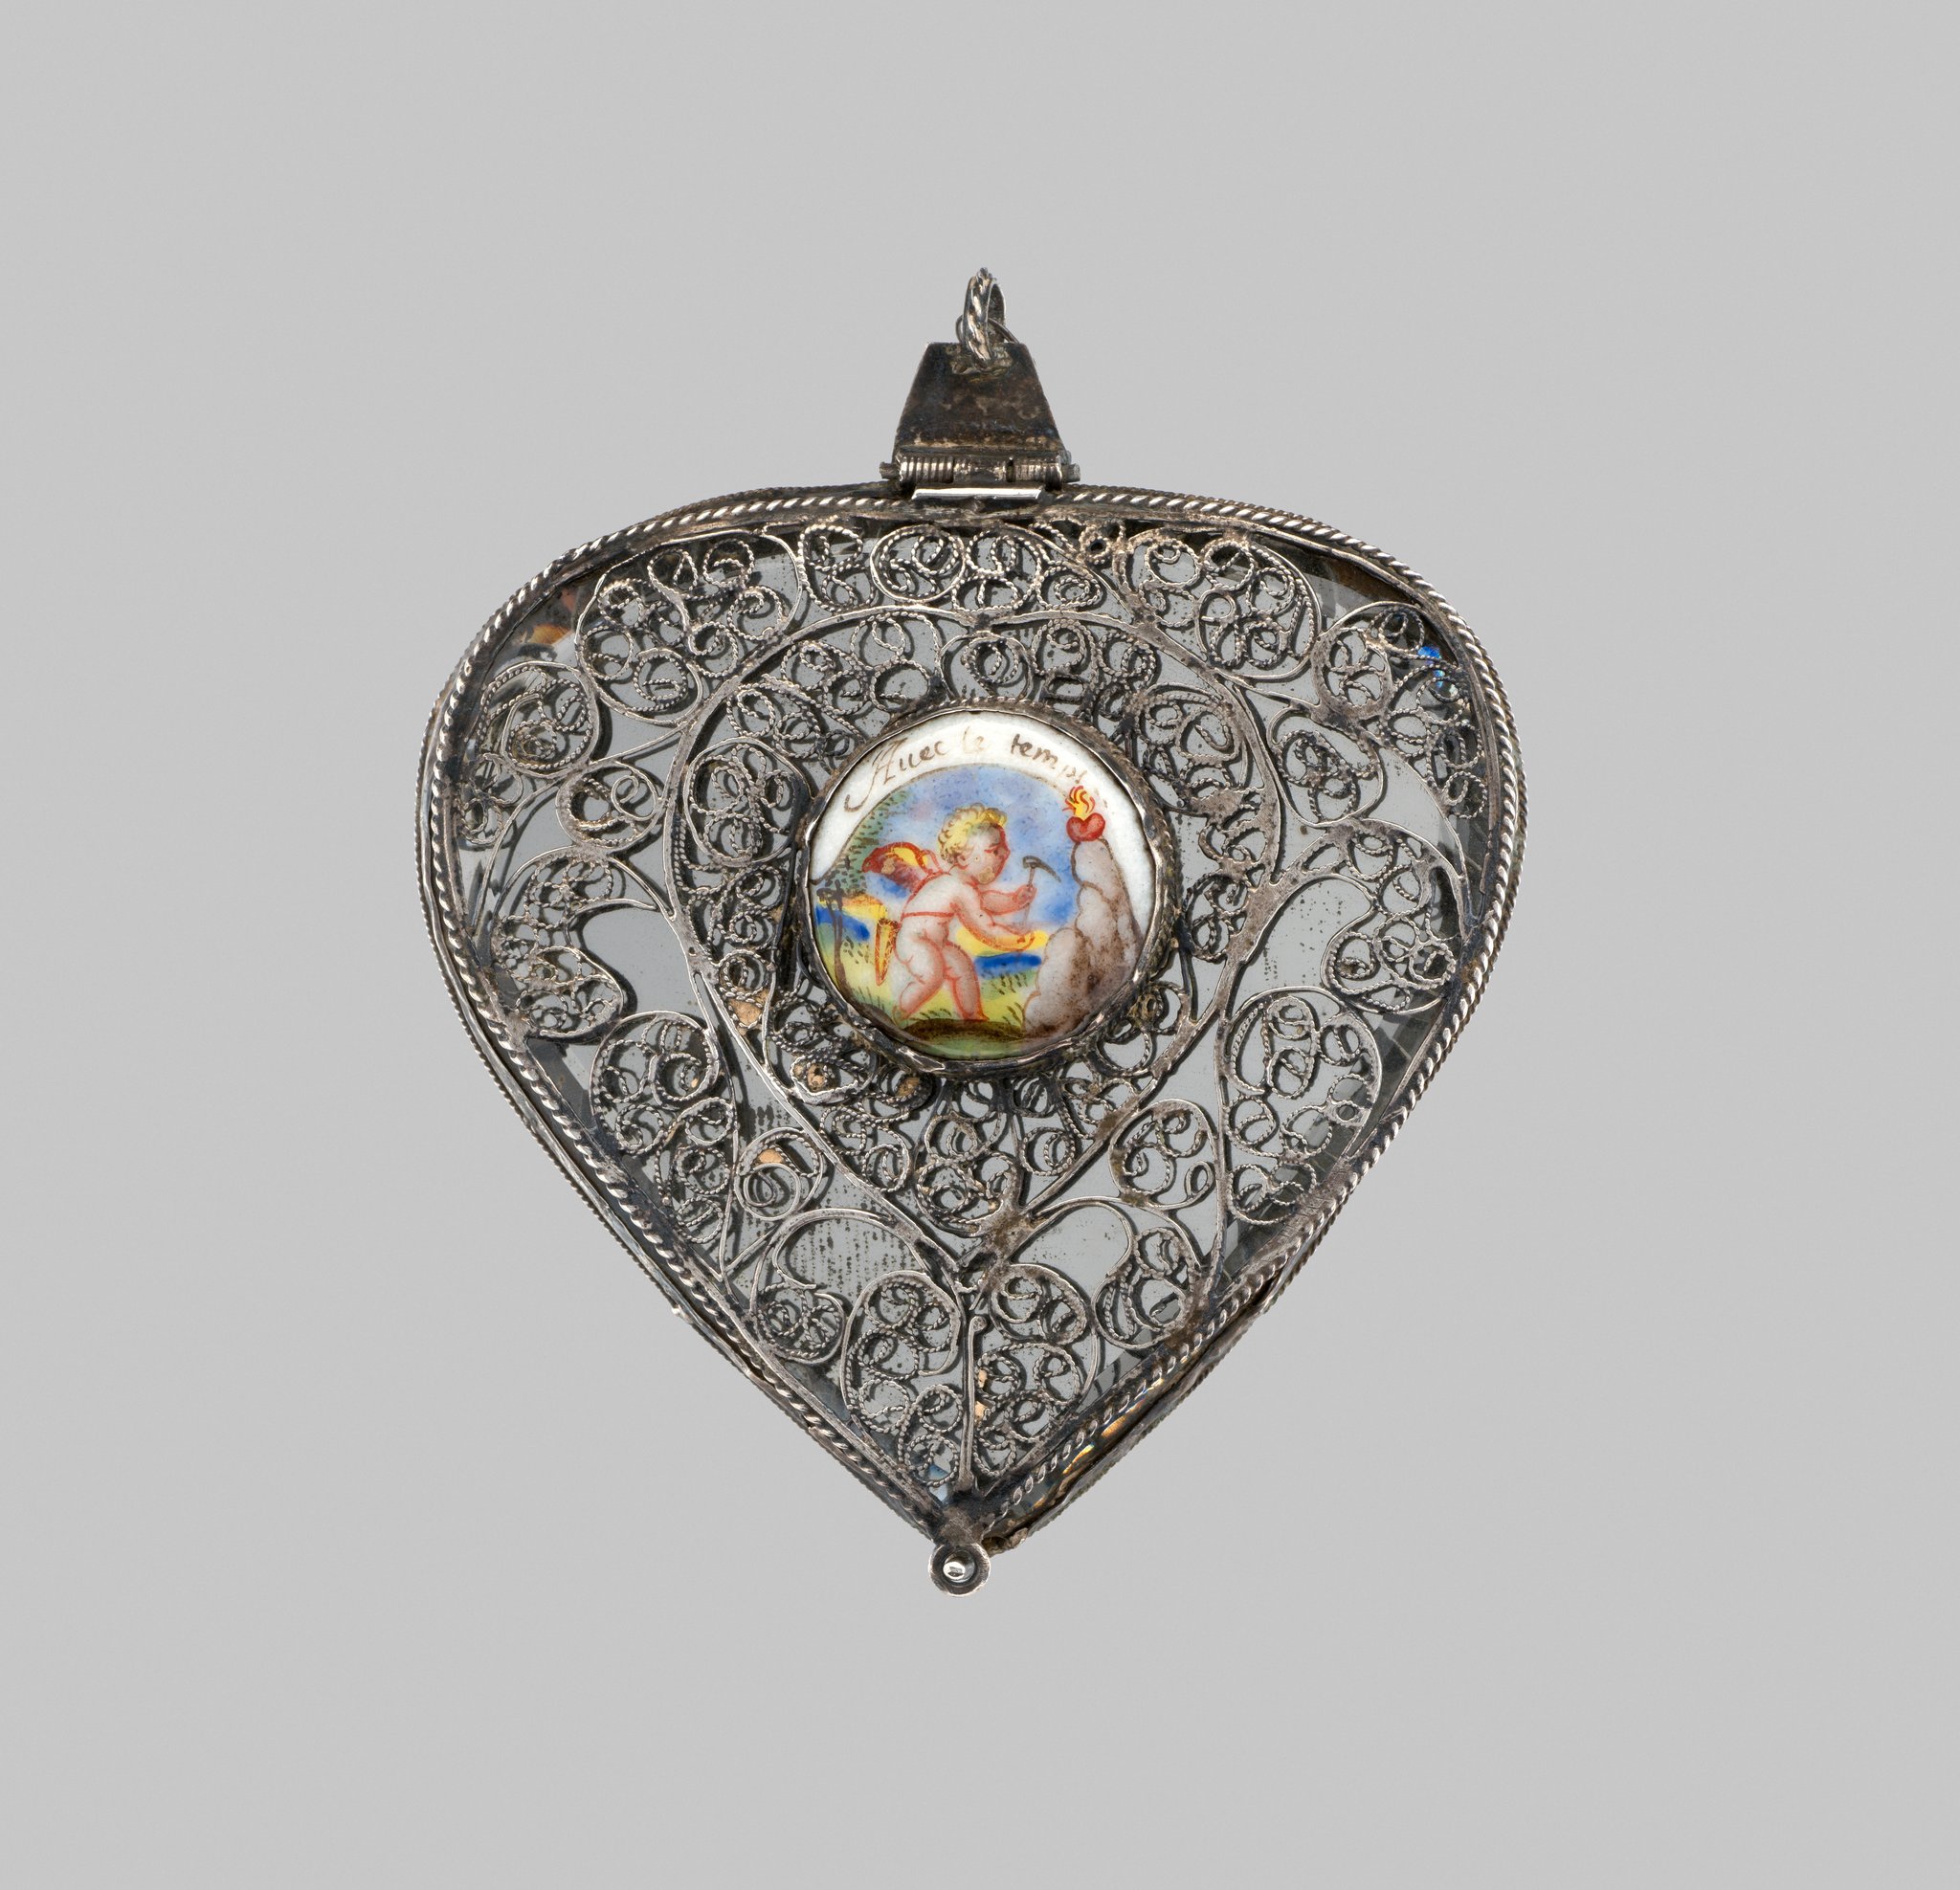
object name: mirror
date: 1601-1700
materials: enamel, silver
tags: cupid